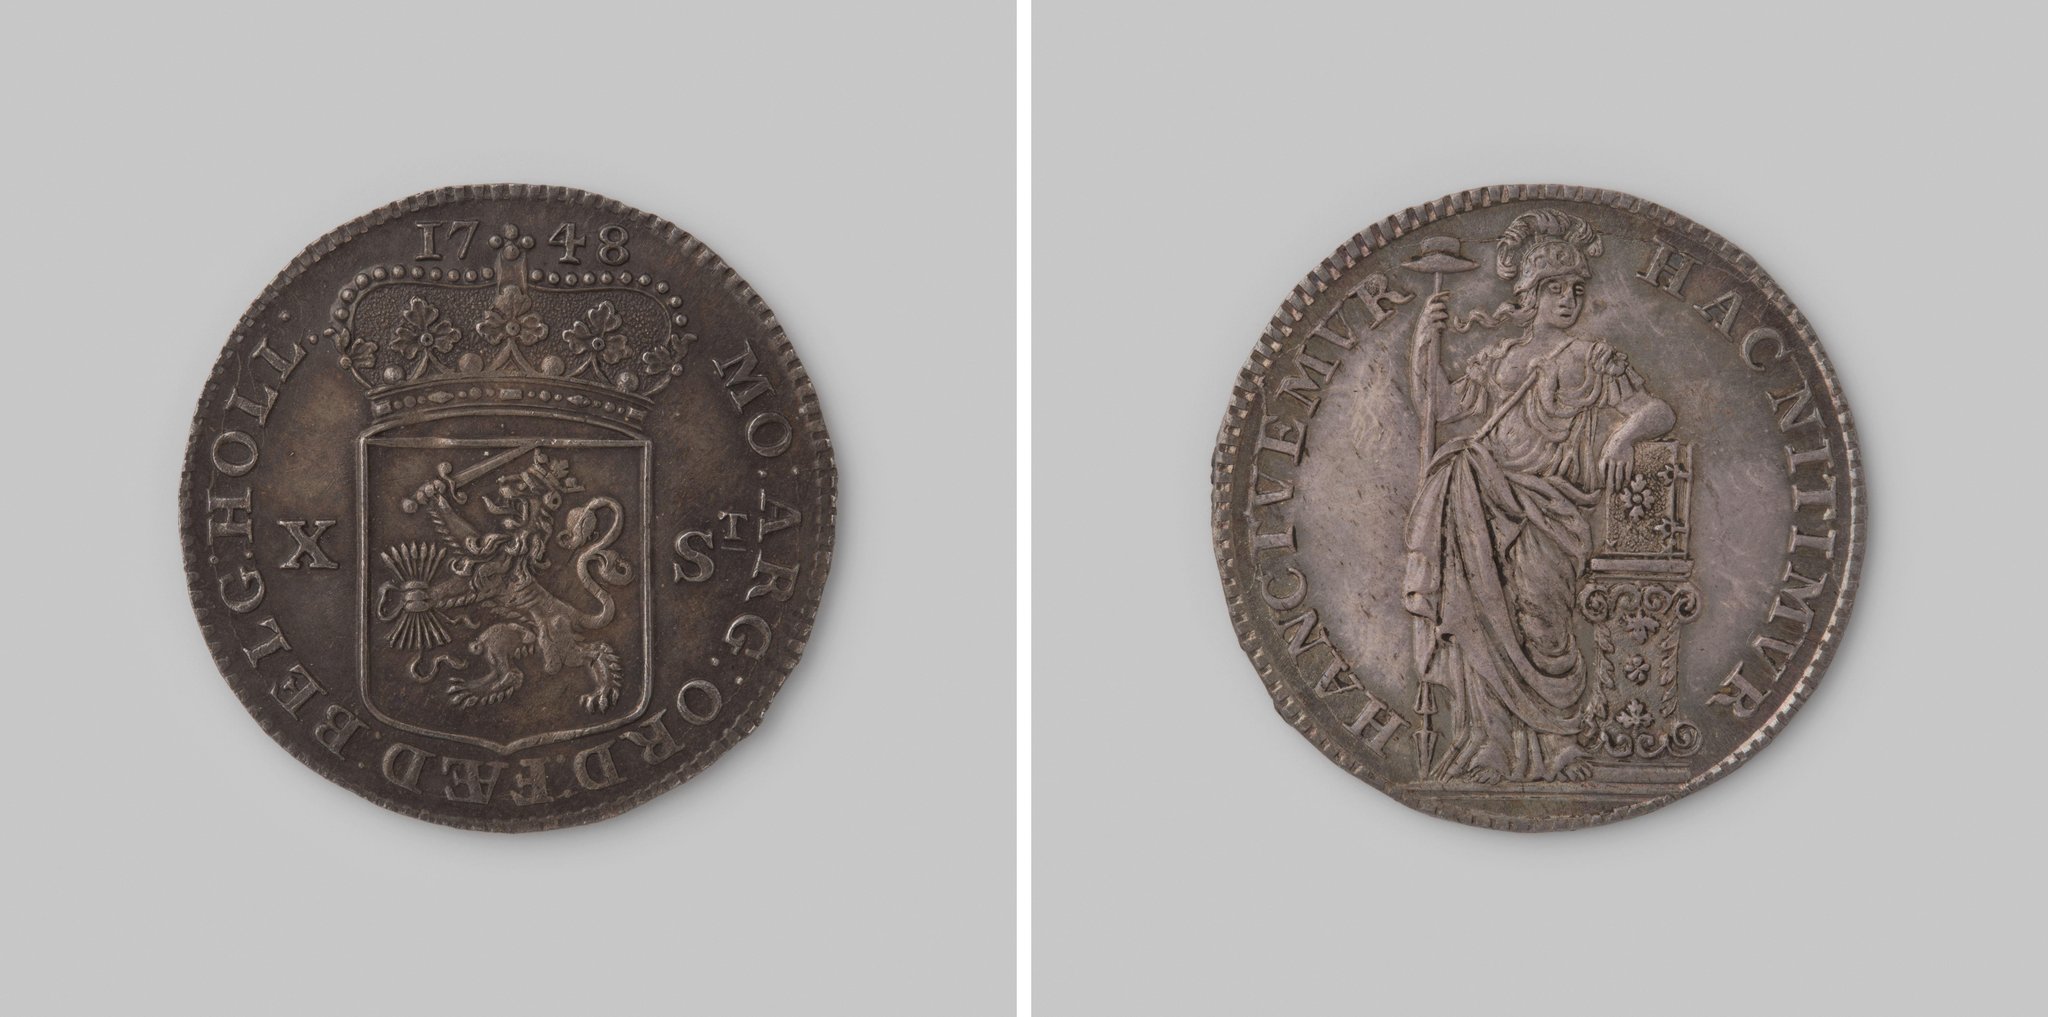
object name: coin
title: Hollandse halve gulden, 1748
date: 1748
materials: silver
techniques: striking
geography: dordrecht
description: Zilveren munt. Voorzijde: tussen waarde-aanduiding X St gekroond generaliteitswapenschild. Jaartal boven kroon. Keerzijde: staande Nederlandse maagd met in rechterhand speer, waarop hoed en met linkerhand steunend op altaar, waarop bijbel.